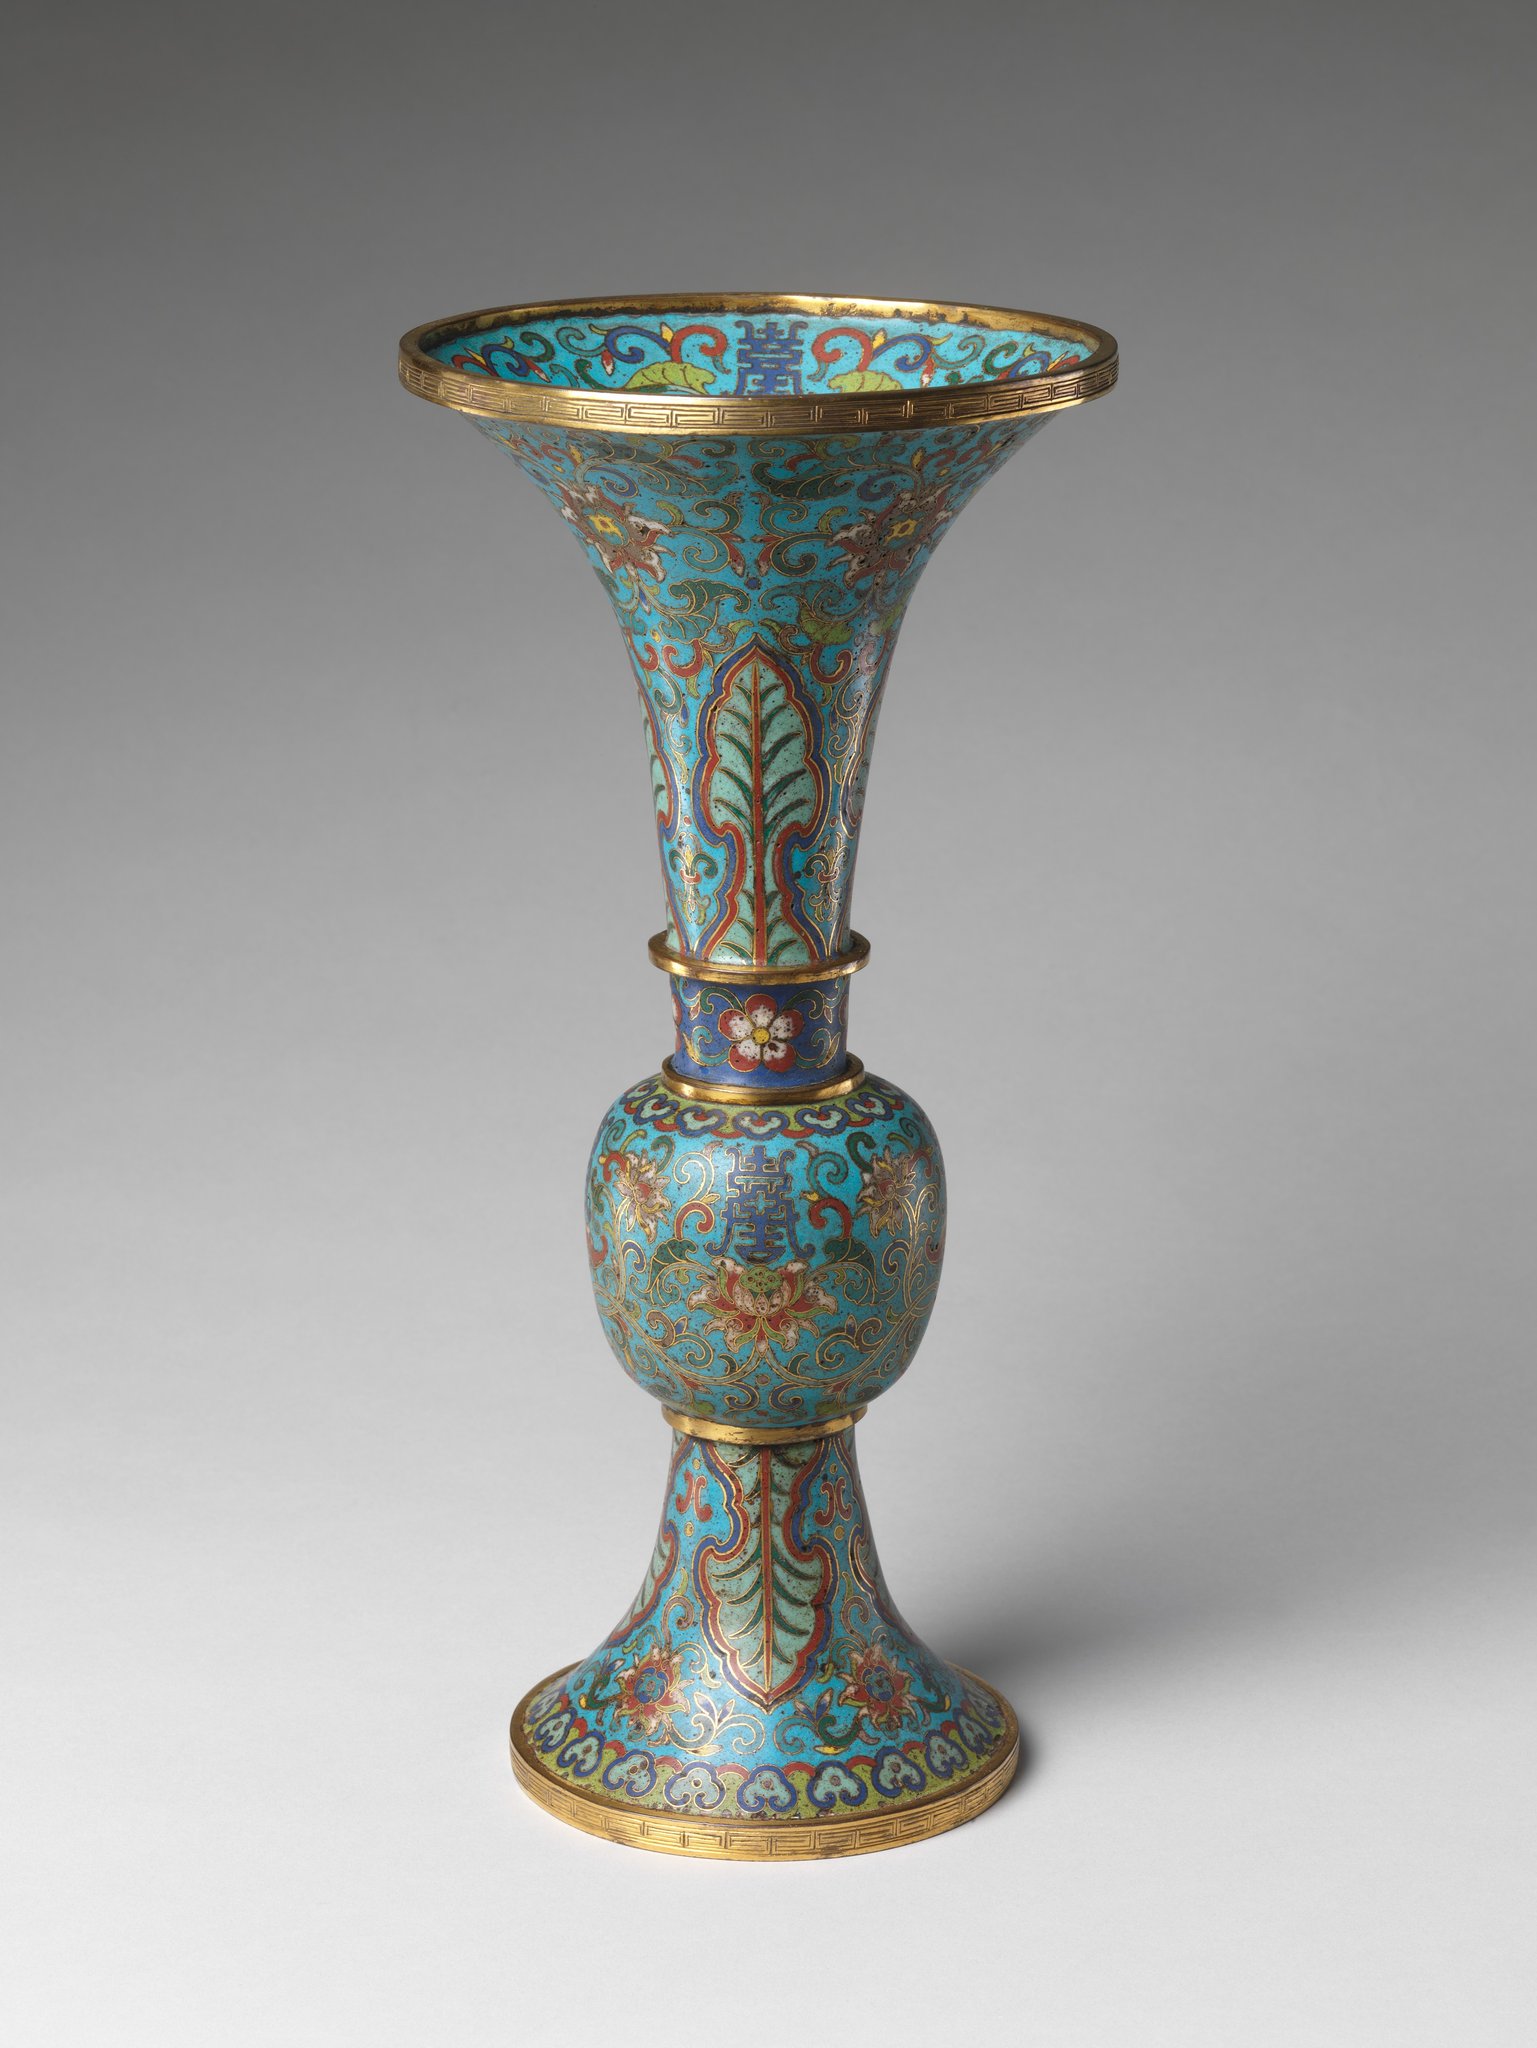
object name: vase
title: Vase from a Set of Five-Piece Altar Set (Wugong)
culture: chinese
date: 1701-1800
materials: copper, enamel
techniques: enamel